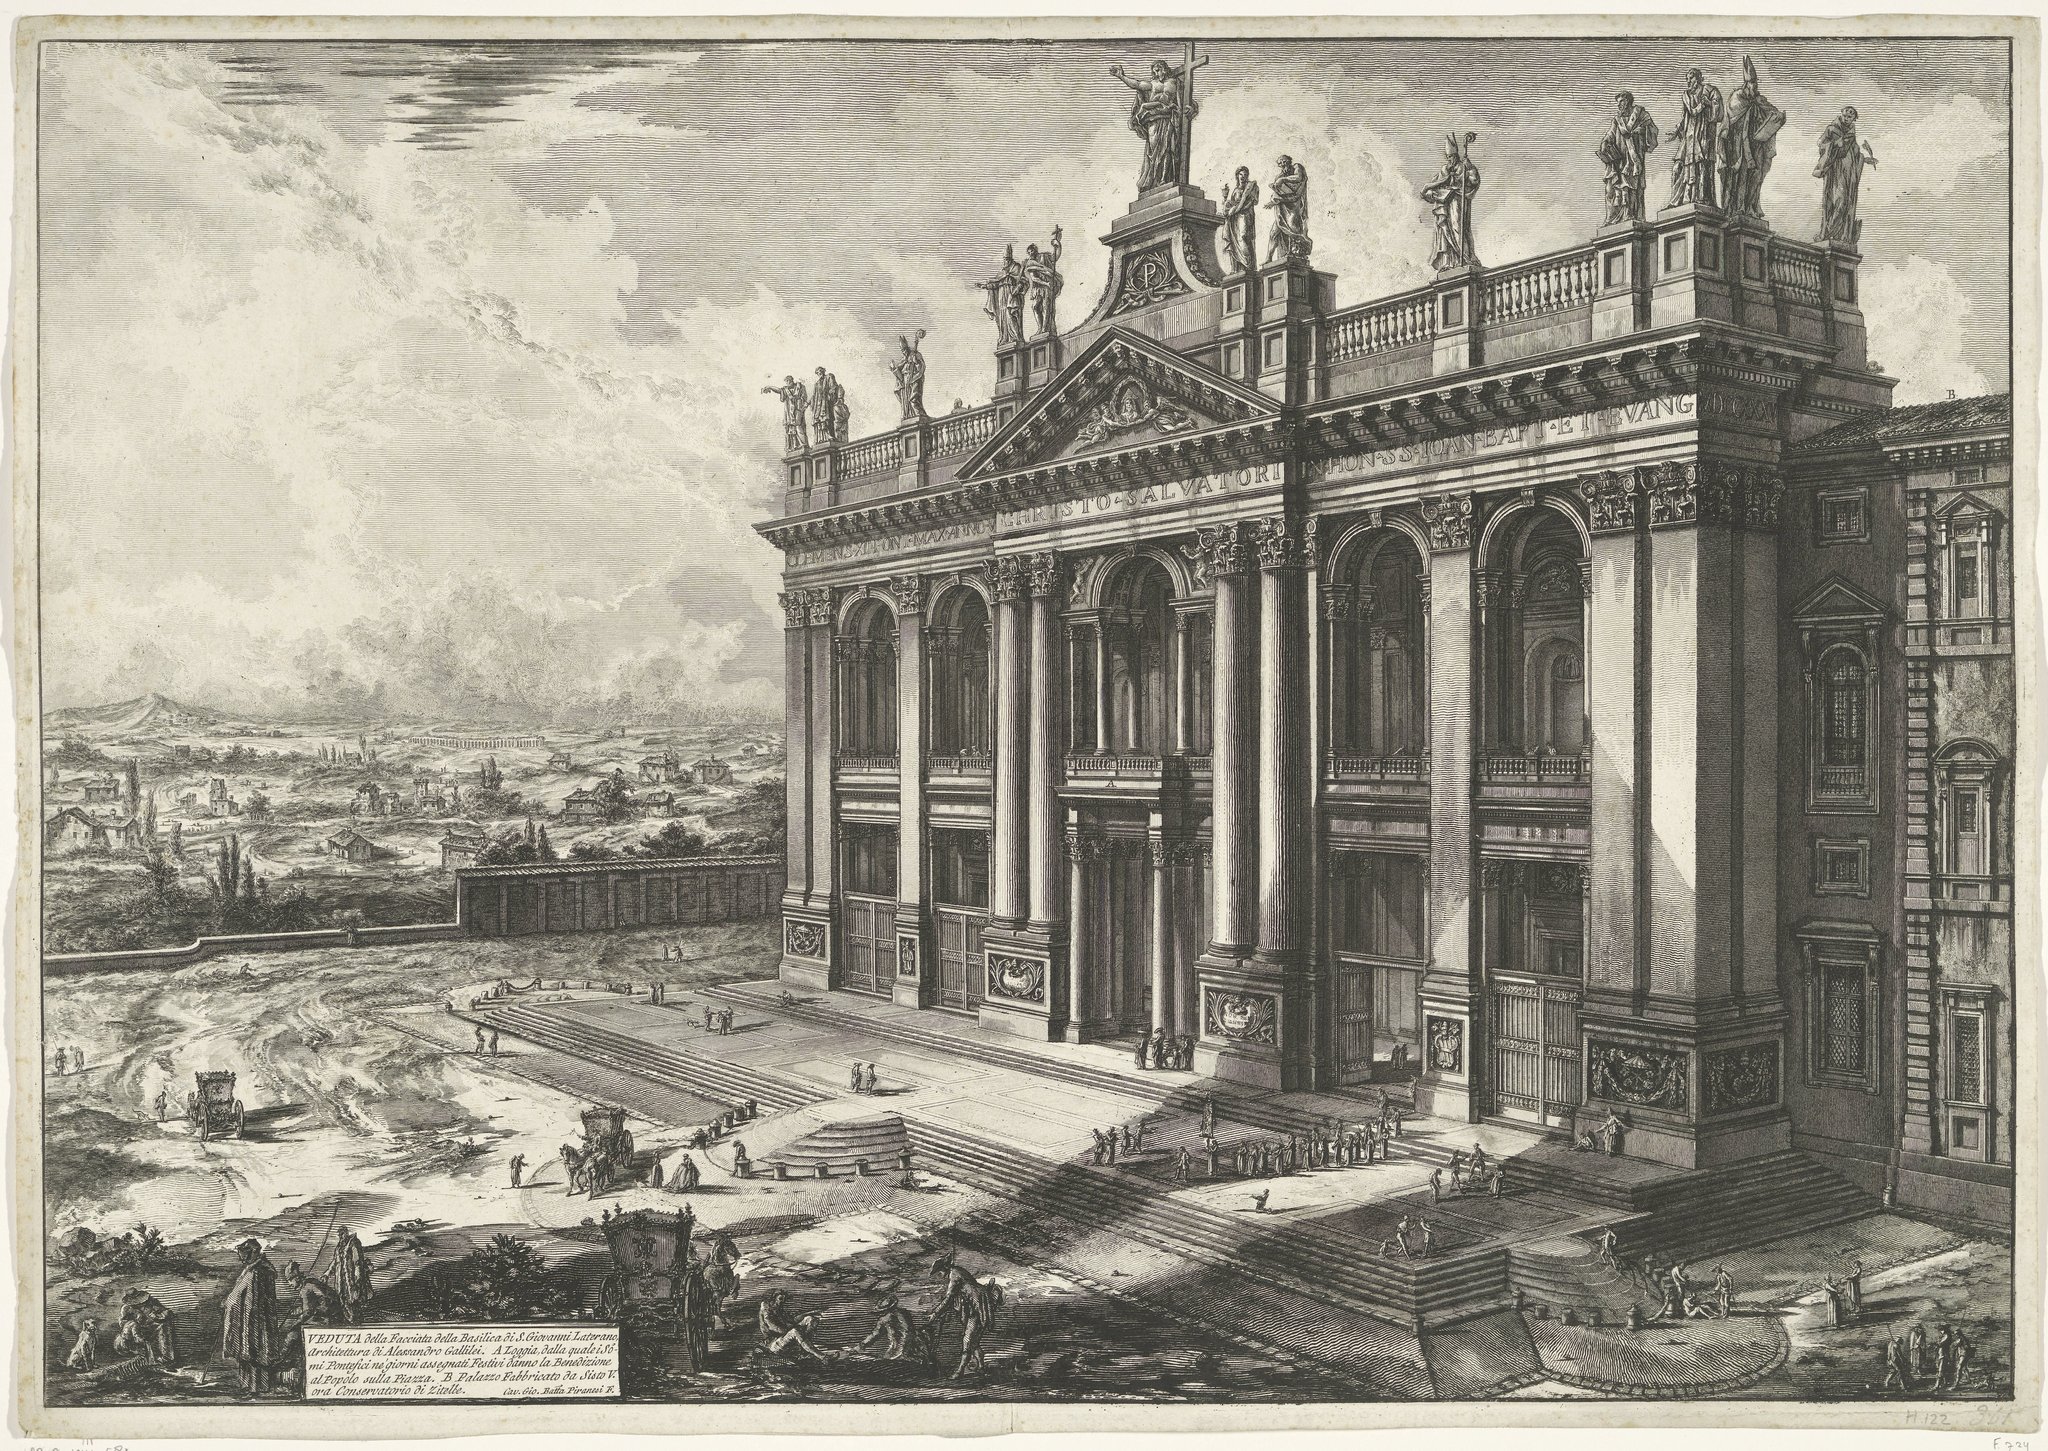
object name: print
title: Sint-Jan van Lateranen te Rome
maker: giovanni battista piranesi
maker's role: designer, draughtsman, print maker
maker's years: 1720-1778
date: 1748-1778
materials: paper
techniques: etching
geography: rome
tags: church (exterior), roman catholic church, parts of church exterior and annexes: façade, rome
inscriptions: collector's mark: Lugt 2228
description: Deze prent maakt deel uit van de serie 'Vedute di Roma'. Piranesi werkte aan deze 135 platen tellende serie tussen 1748 en zijn dood in 1778. Francesco Piranesi voegde later nog twee prenten toe aan de reeks van zijn vader.